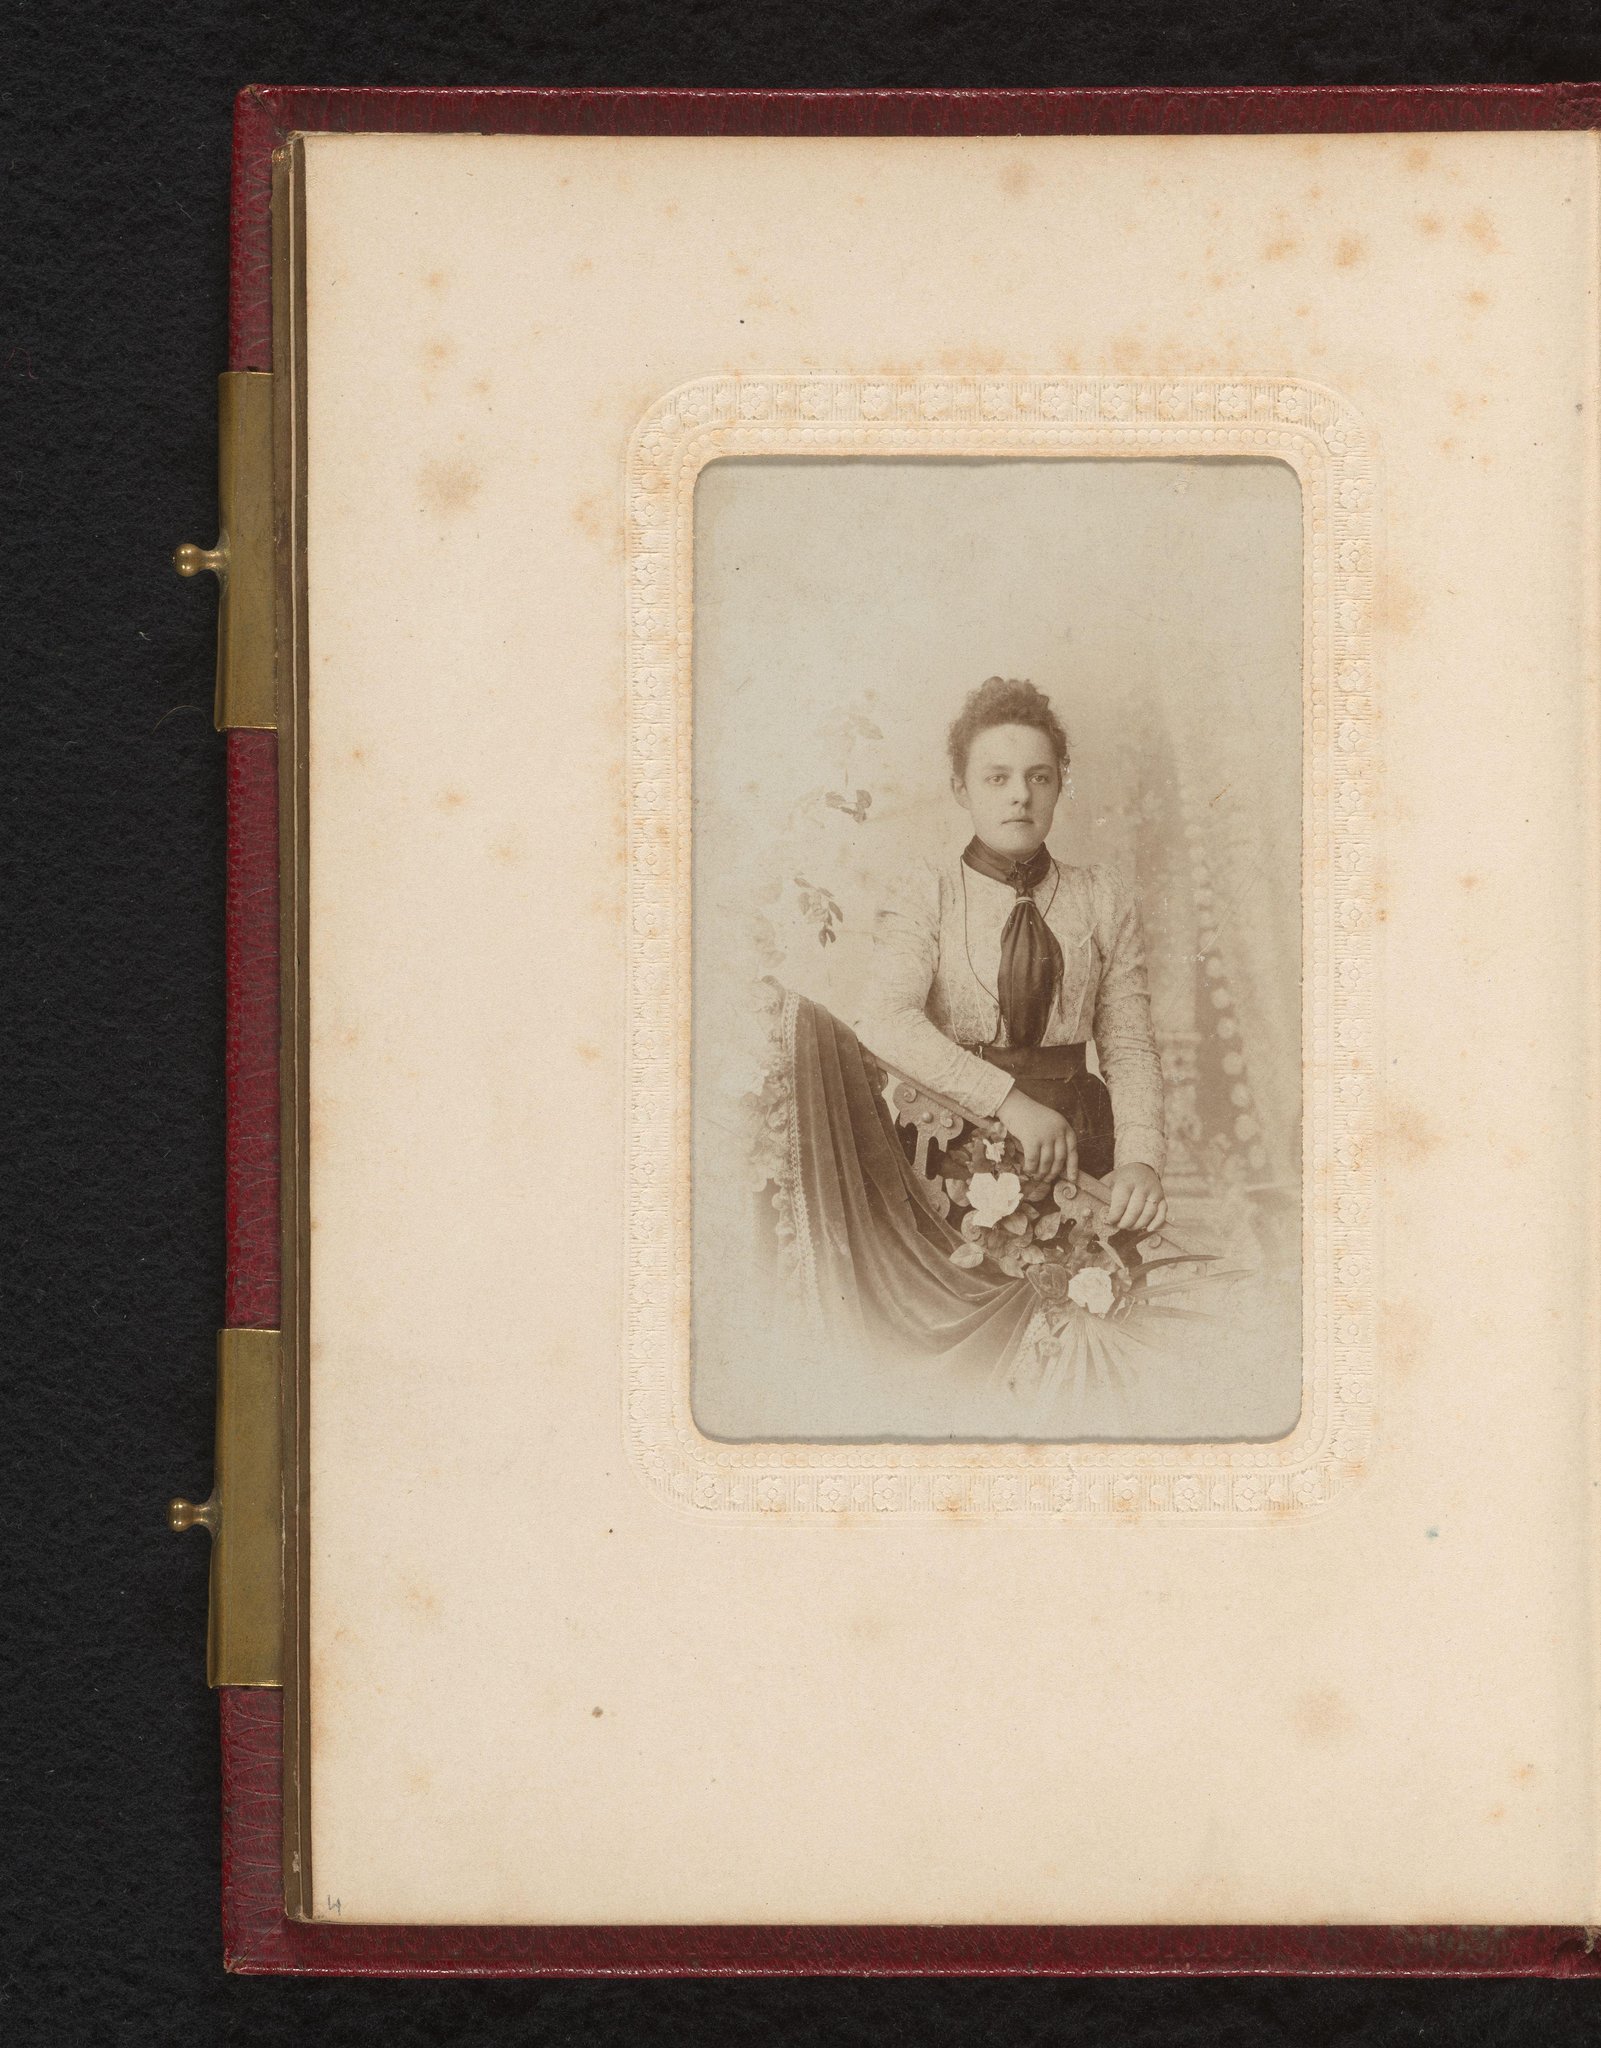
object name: photograph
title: Portret van vrouw, staand bij een leuning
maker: salomon goudsmit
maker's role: fotograaf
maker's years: 1864-1919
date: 1895-1919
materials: cardboard, photographic support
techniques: collodion silver print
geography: enschede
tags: historical persons, balustrade, standing figure - aa - female human figure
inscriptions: inscription: ‘Fotogr./ Atelier/ S. Goudsmit/ Haverstraat/ Enschede./ Vergrootingen naar elk Portret in Artistique bewerking.’